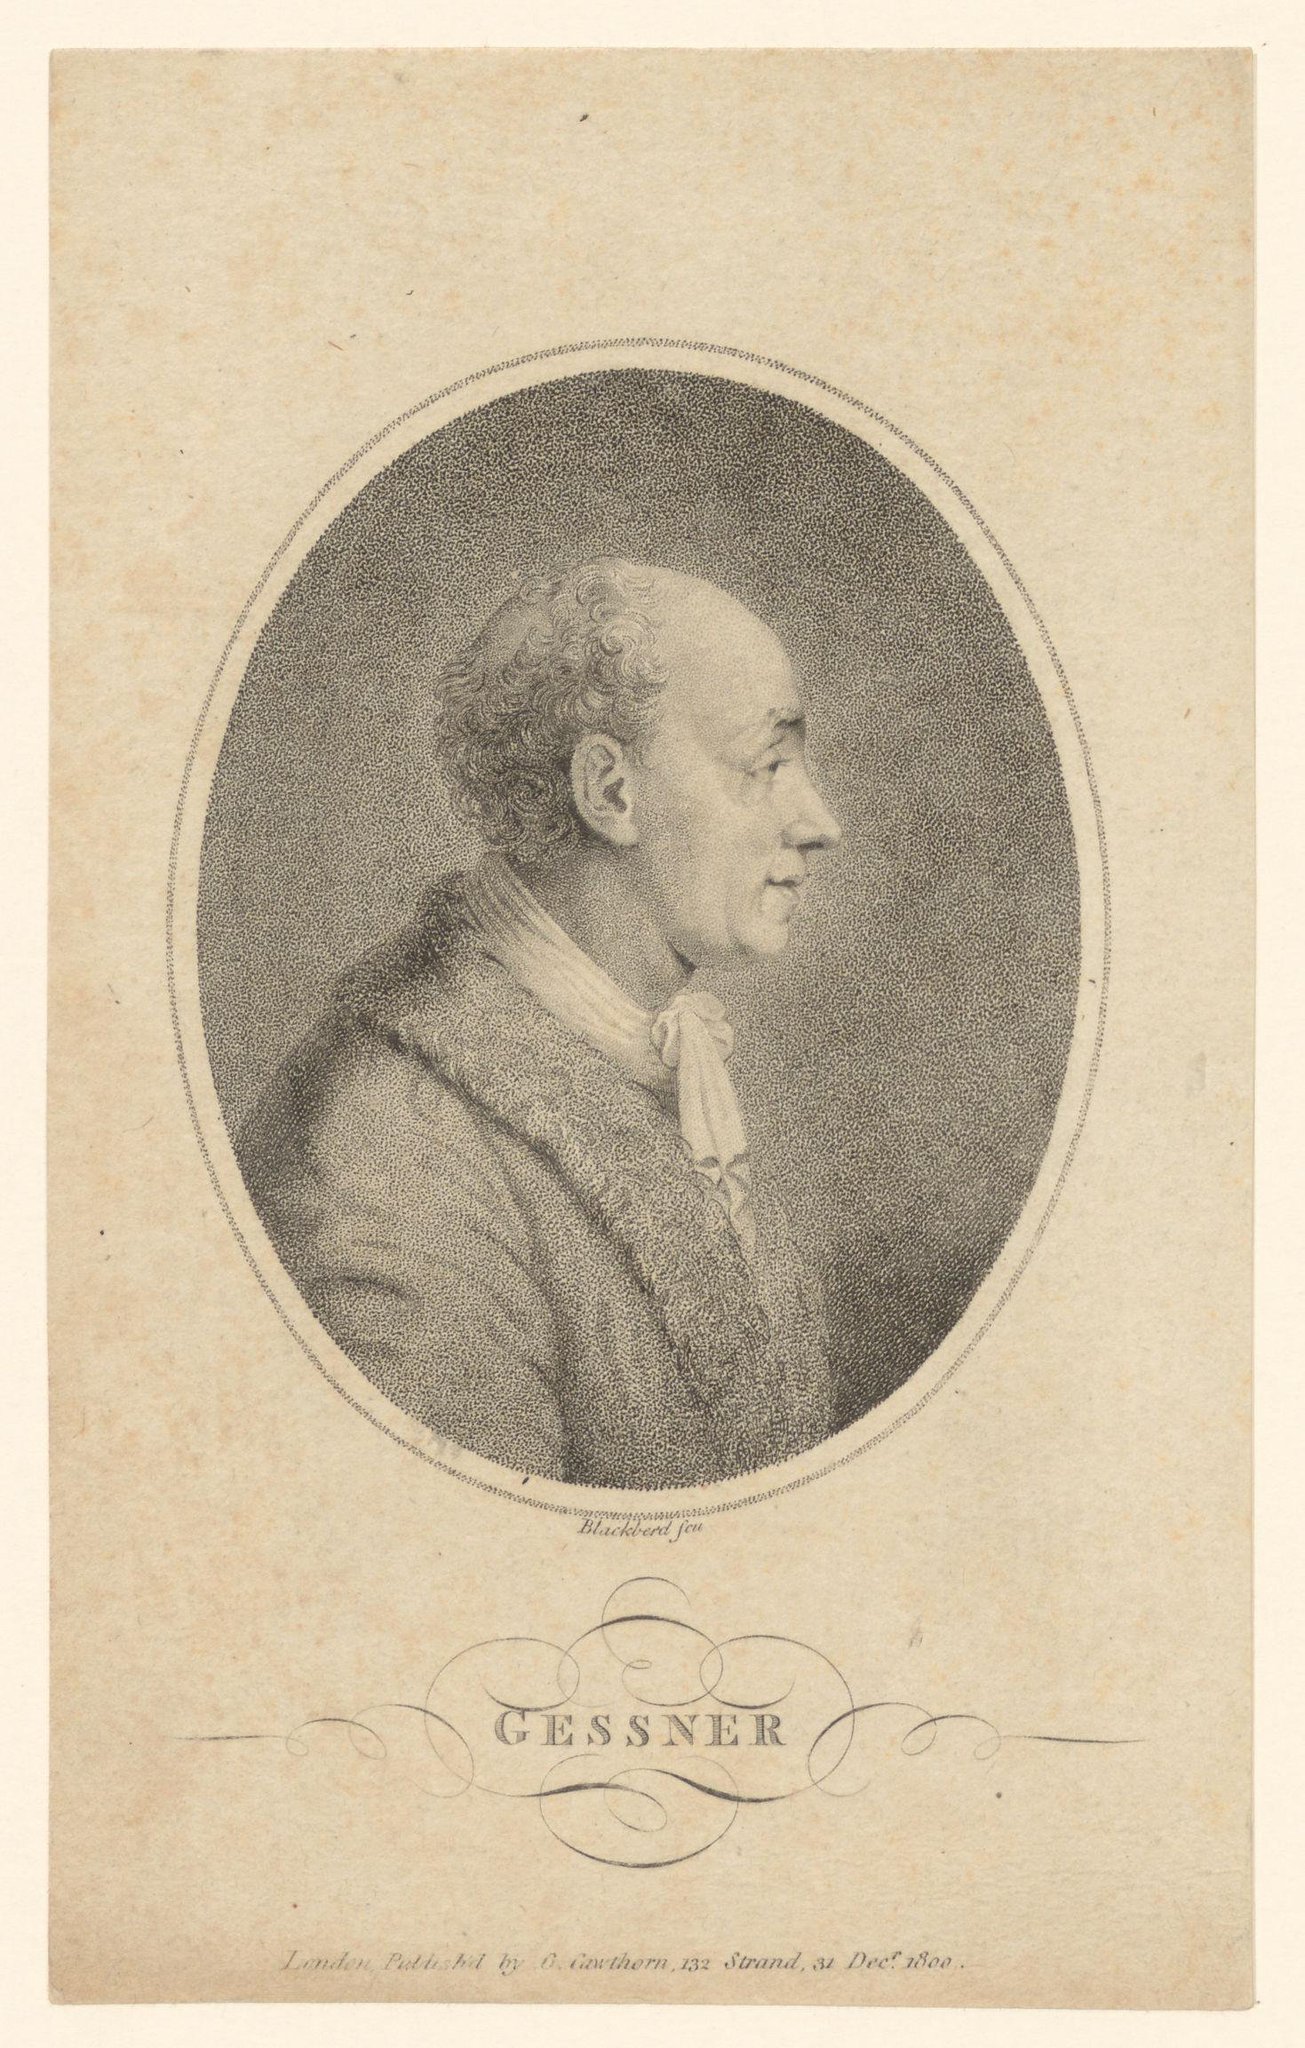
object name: print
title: Portret van Salomon Gessner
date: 1800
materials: paper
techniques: engraving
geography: london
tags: painter, salomon gessner, historical persons, portrait, self-portrait of painter, portrait, self-portrait of graphic artist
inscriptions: collector's mark: Lugt 2228